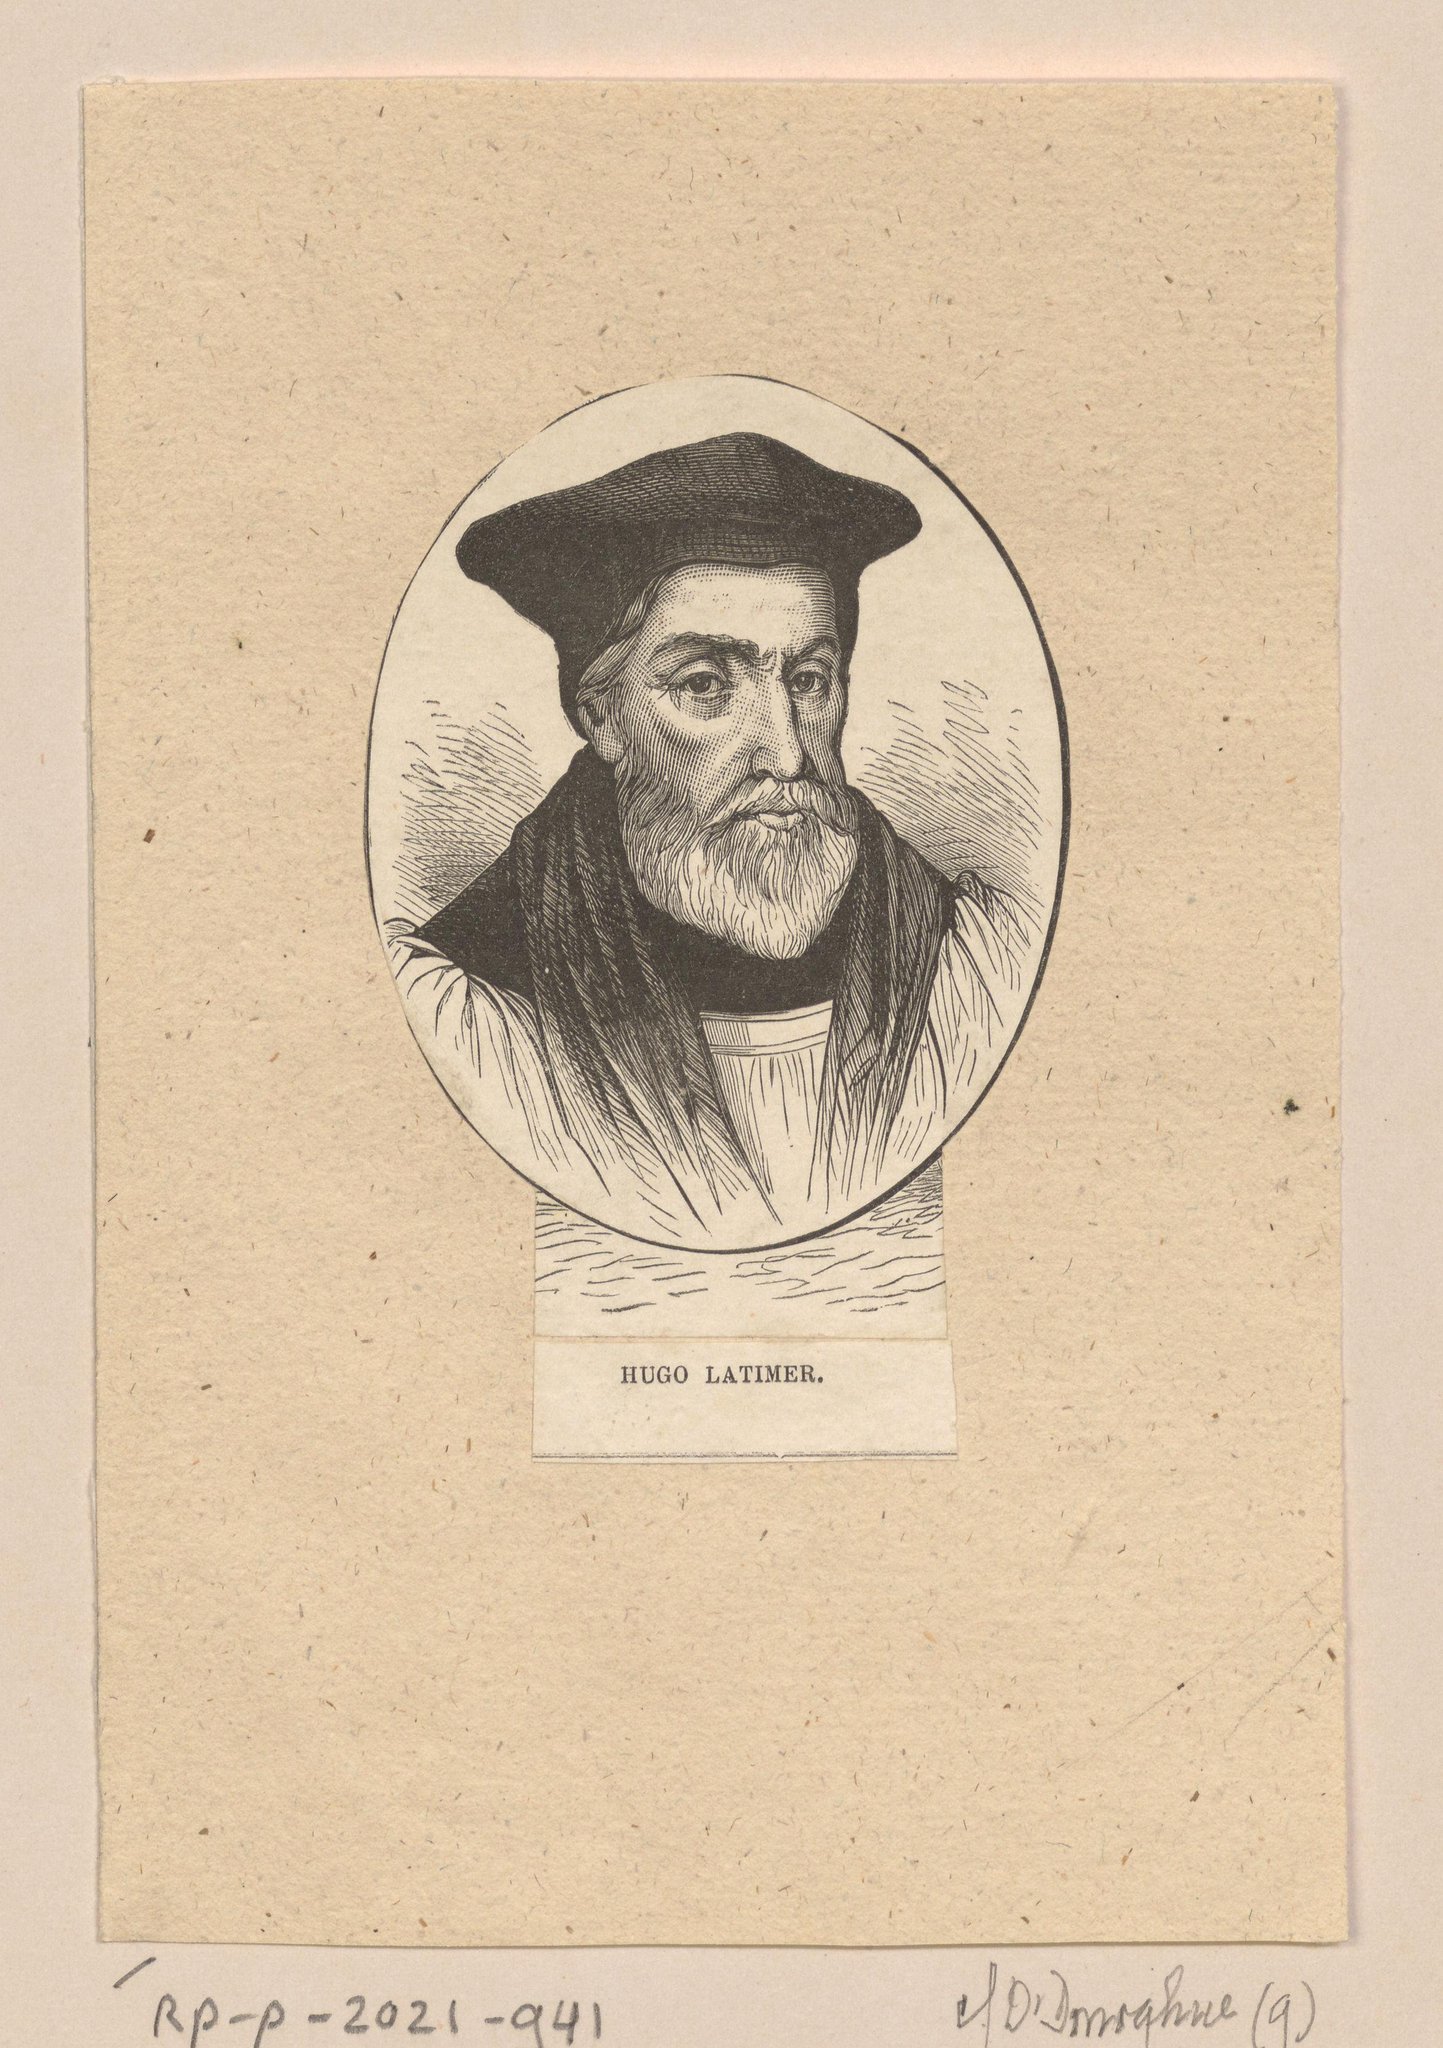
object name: print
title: Portret van Hugh Latimer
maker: Anonymous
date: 1800-1899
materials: paper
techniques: engraving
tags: archbishop, bishop, etc. (roman catholic), historical persons